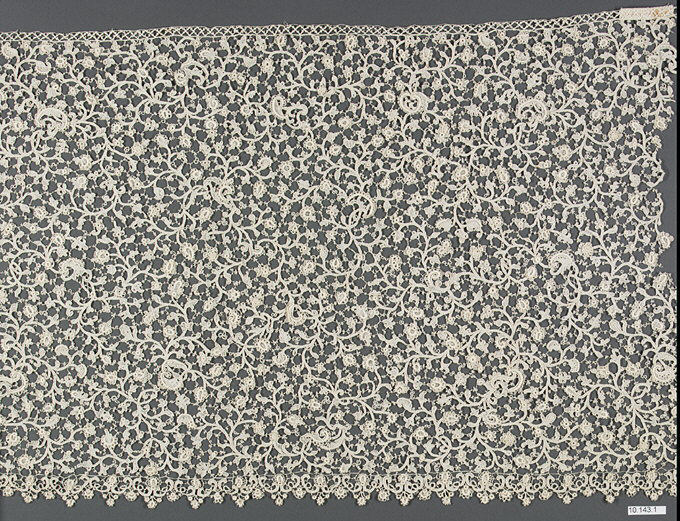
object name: flounce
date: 1667-1700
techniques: lace